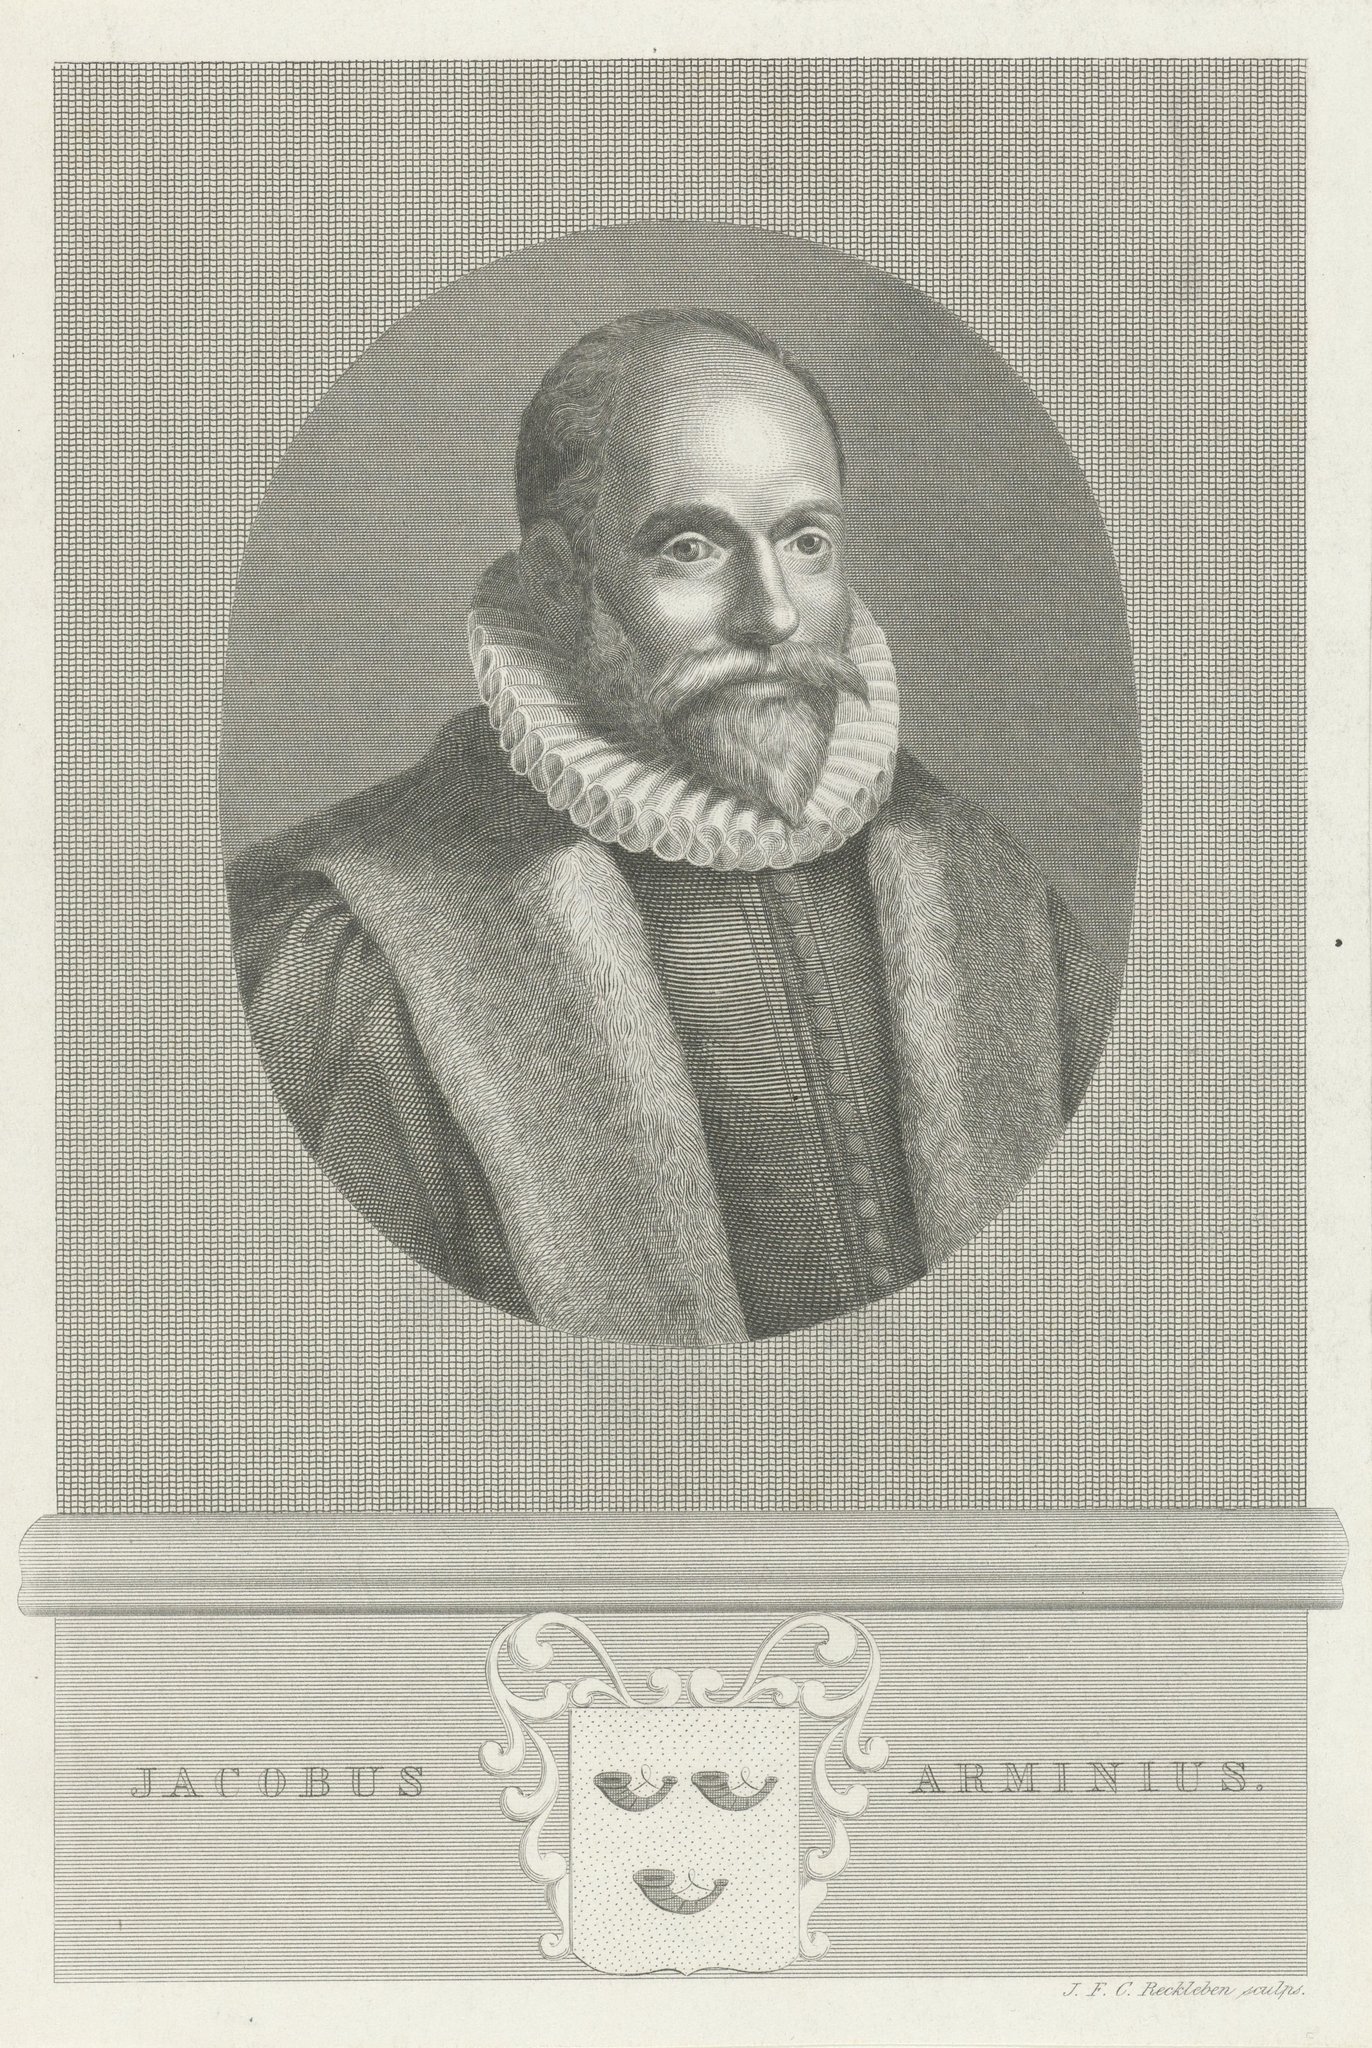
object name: print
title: Portret van Jacobus Arminius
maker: jan frederik christiaan reckleben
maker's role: print maker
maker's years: 1819-1879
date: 1855-1857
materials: paper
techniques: engraving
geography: amsterdam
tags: oudewater, predikant, jacobus arminius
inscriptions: collector's mark: Lugt 2228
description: Illustratie in: Arend, Johannes Pieter. Algemeene geschiedenis des vaderlands van de vroegste tijden tot op heden. 5 delen, Amsterdam: Schleijer, J.F. 1840-1884, dl. 3.2, p. 417. Het portret is waarschijnlijk gebaseerd op de prent van Willem van Swanenburgh naar een verloren gegaan schilderij van Michiel van Miereveld.